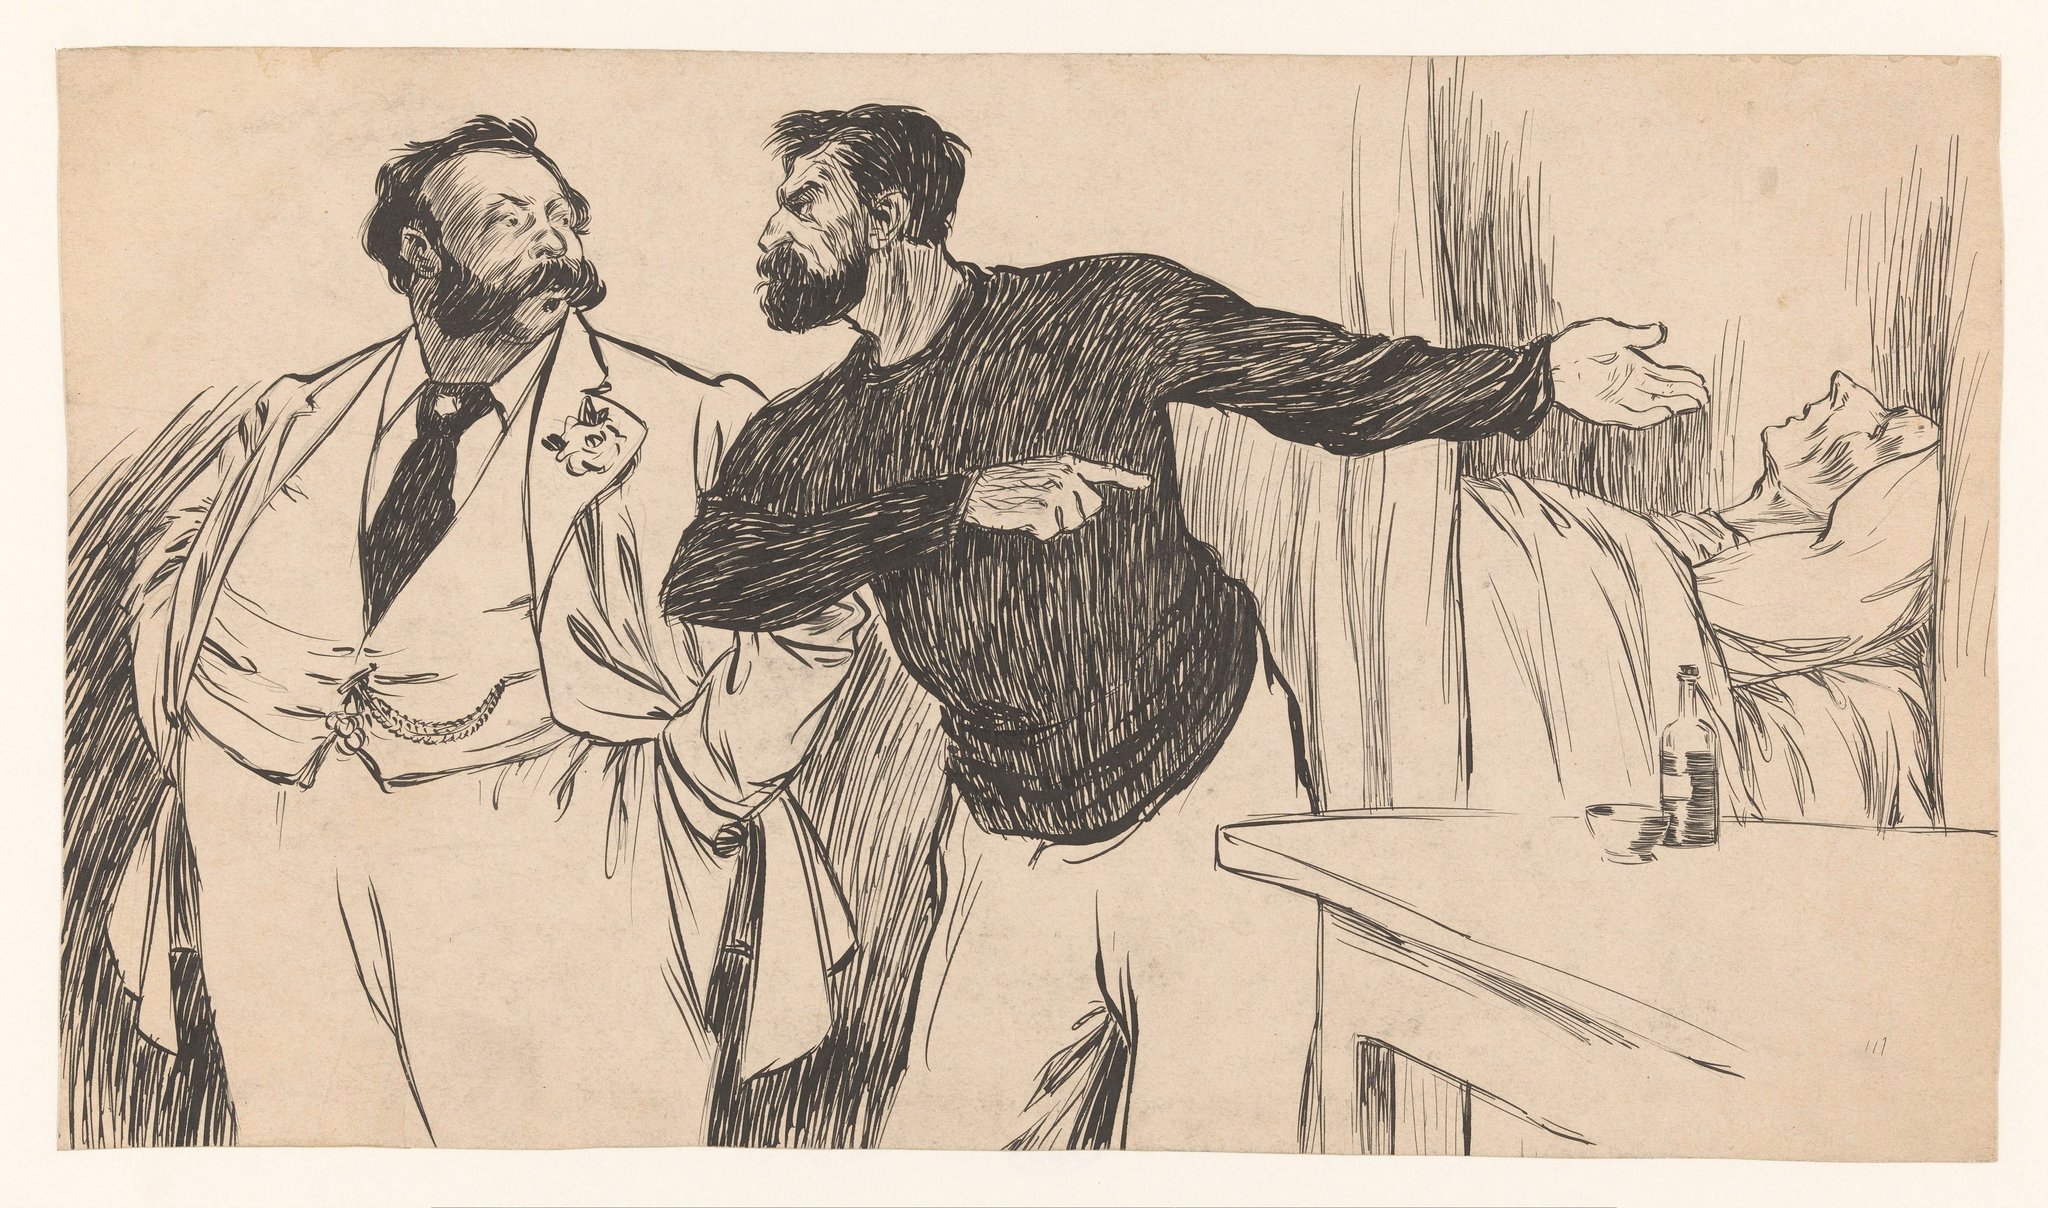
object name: drawing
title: Eigenaar van fabriek bij overleden vrouw van een arbeider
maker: jan de waardt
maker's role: draughtsman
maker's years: 1871-1909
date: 1875-1900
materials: ink, paper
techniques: pen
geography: netherlands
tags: deathbed, the rich, contrast between rich and poor, working class, labourers, netherlands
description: Links een dikke heer met grote snor in wit pak, handen in de broekzakken; rechts een man met baard en zwart trui de rechterhand wijzend naar rechts naar de overleden vrouw met hoofd op kussen, liggend op de rug, lichaam verdwijnt links achter een schot. Rechts een tafel waarop een medicijnfles en een kommetje.